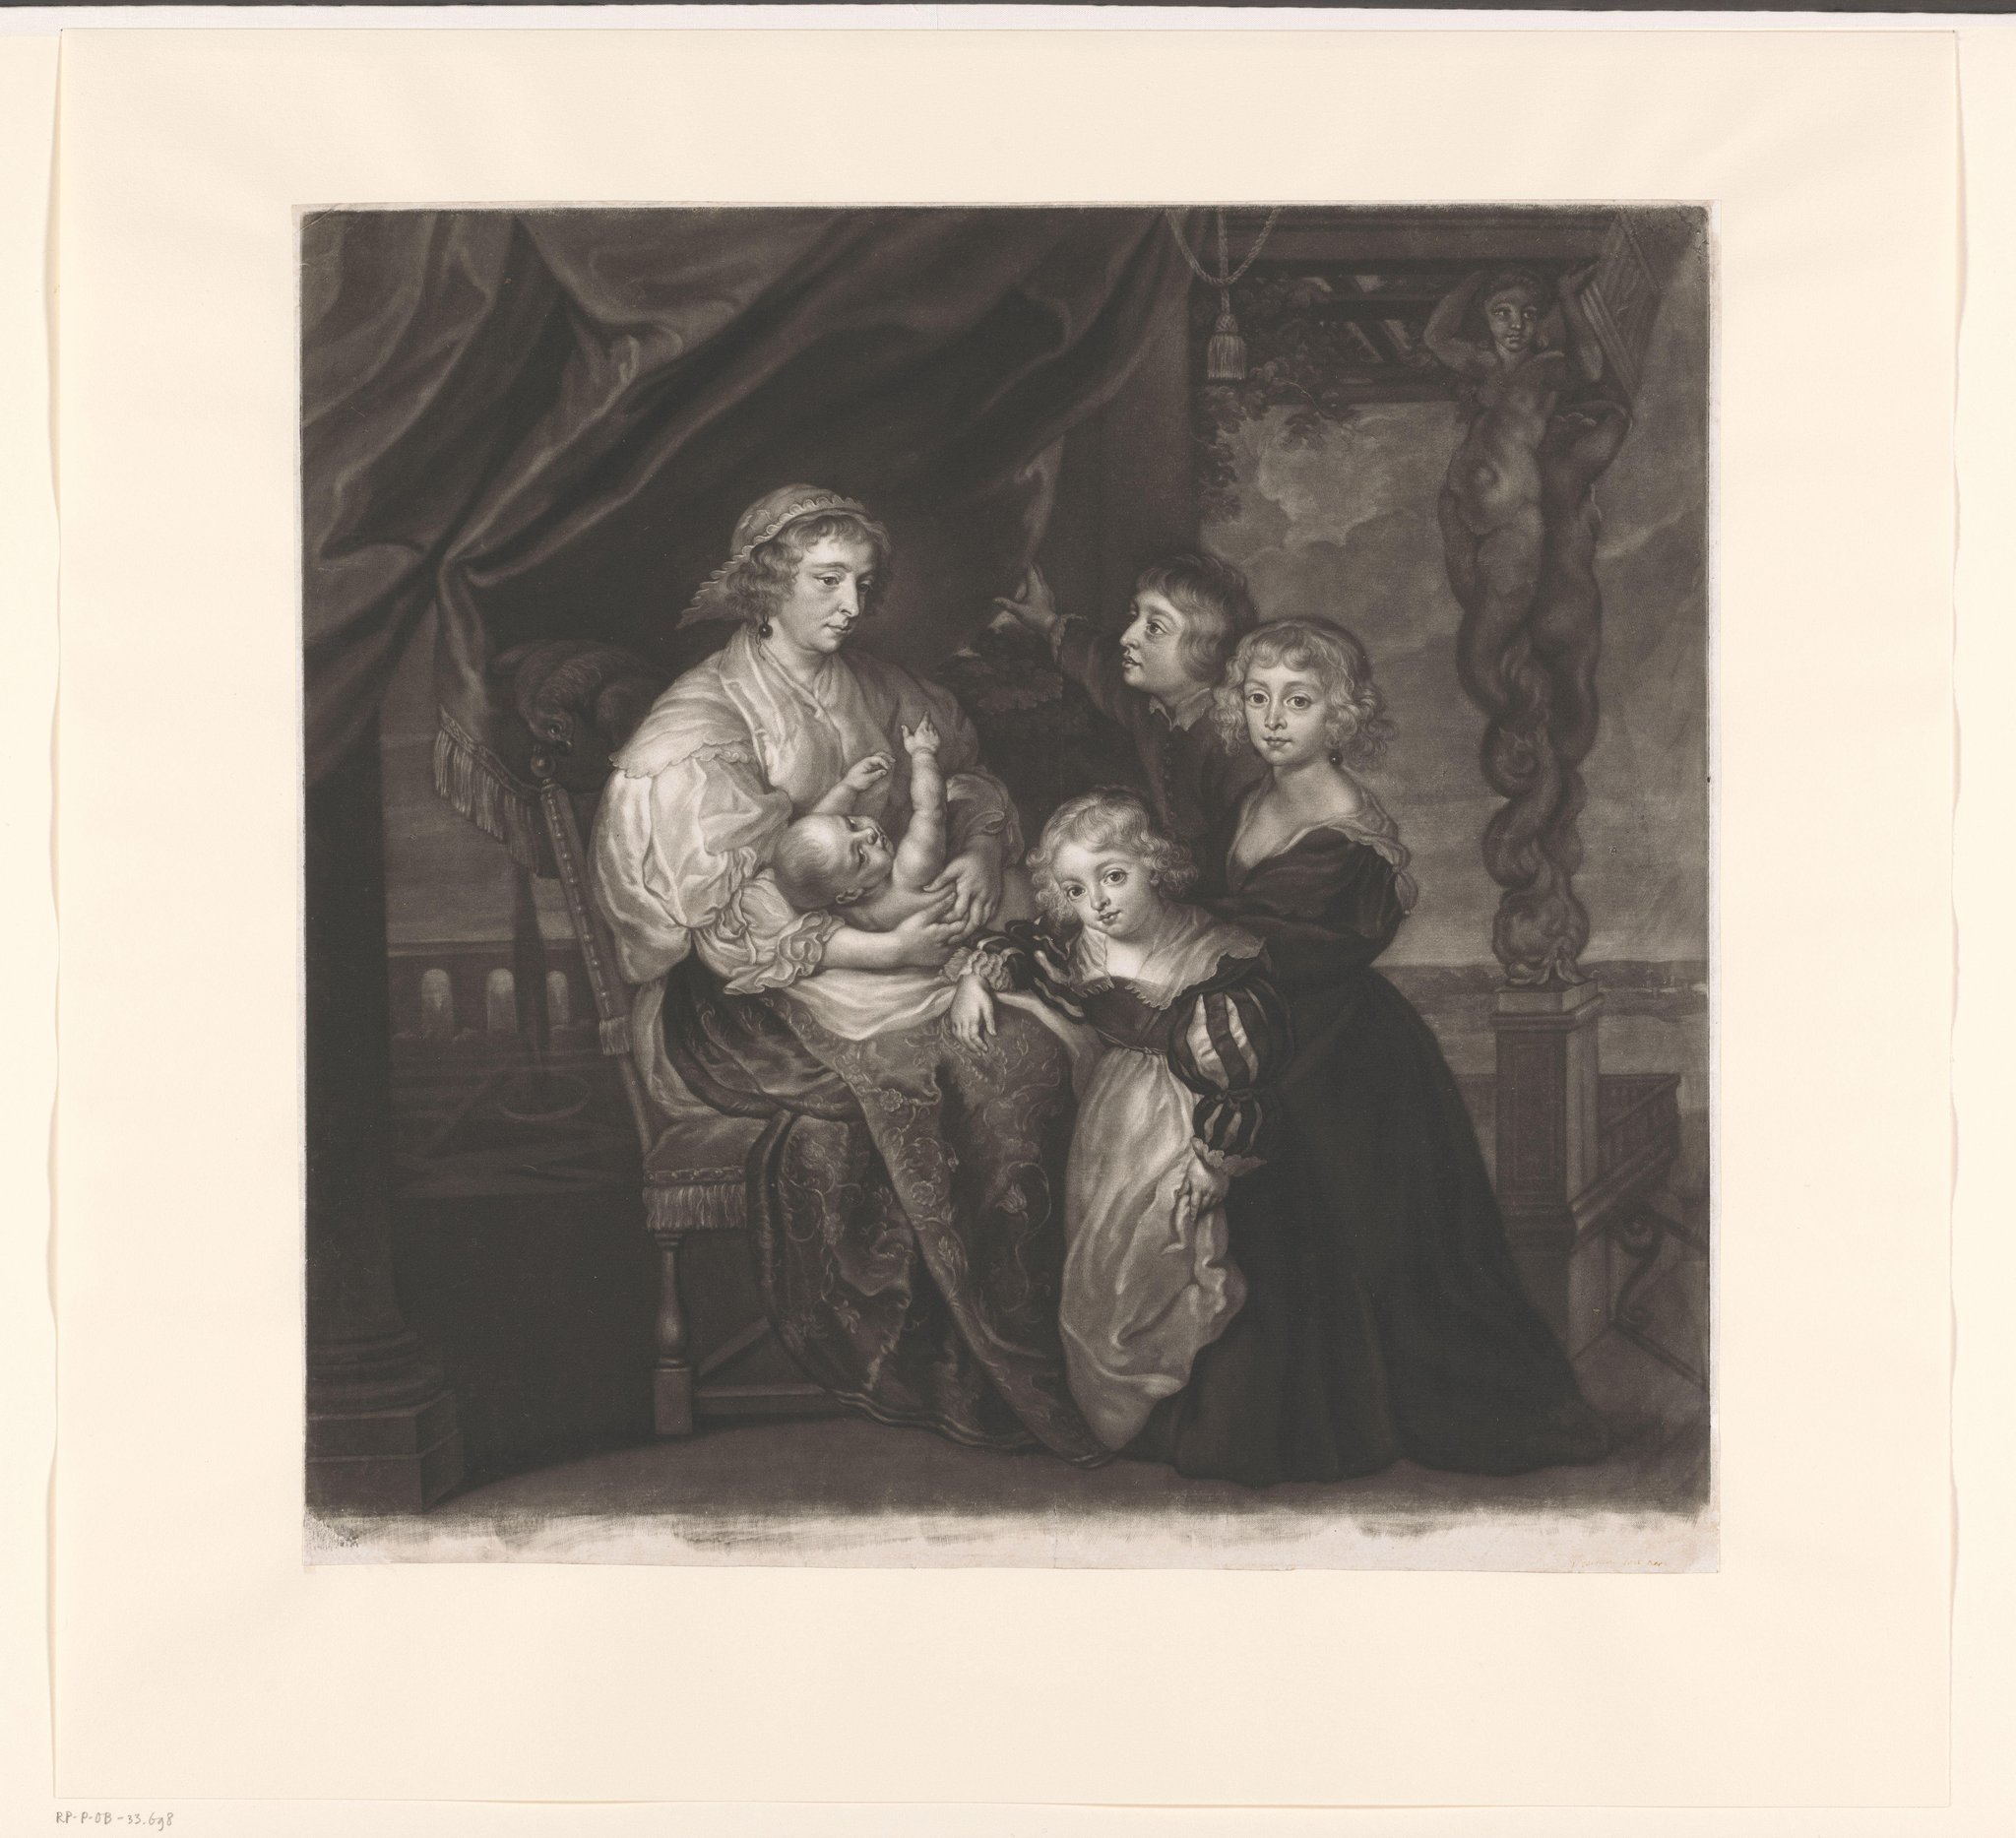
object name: print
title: Portret van Deborah Kip met vier van haar kinderen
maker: james mcardell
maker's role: print maker, publisher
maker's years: 1728-1765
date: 1755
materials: paper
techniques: mezzotint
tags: mother and child(4), woman and child(4) (4) (4), historical person (with name) - historical person (with name) portrayed in a group, in a group-portrait, historical person (with name) - bb - woman - historical person (with name) portrayed in a group, in a group-portrait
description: Naar een schilderij van Rubens en Jordaens in de National Gallery of Art te Washington.